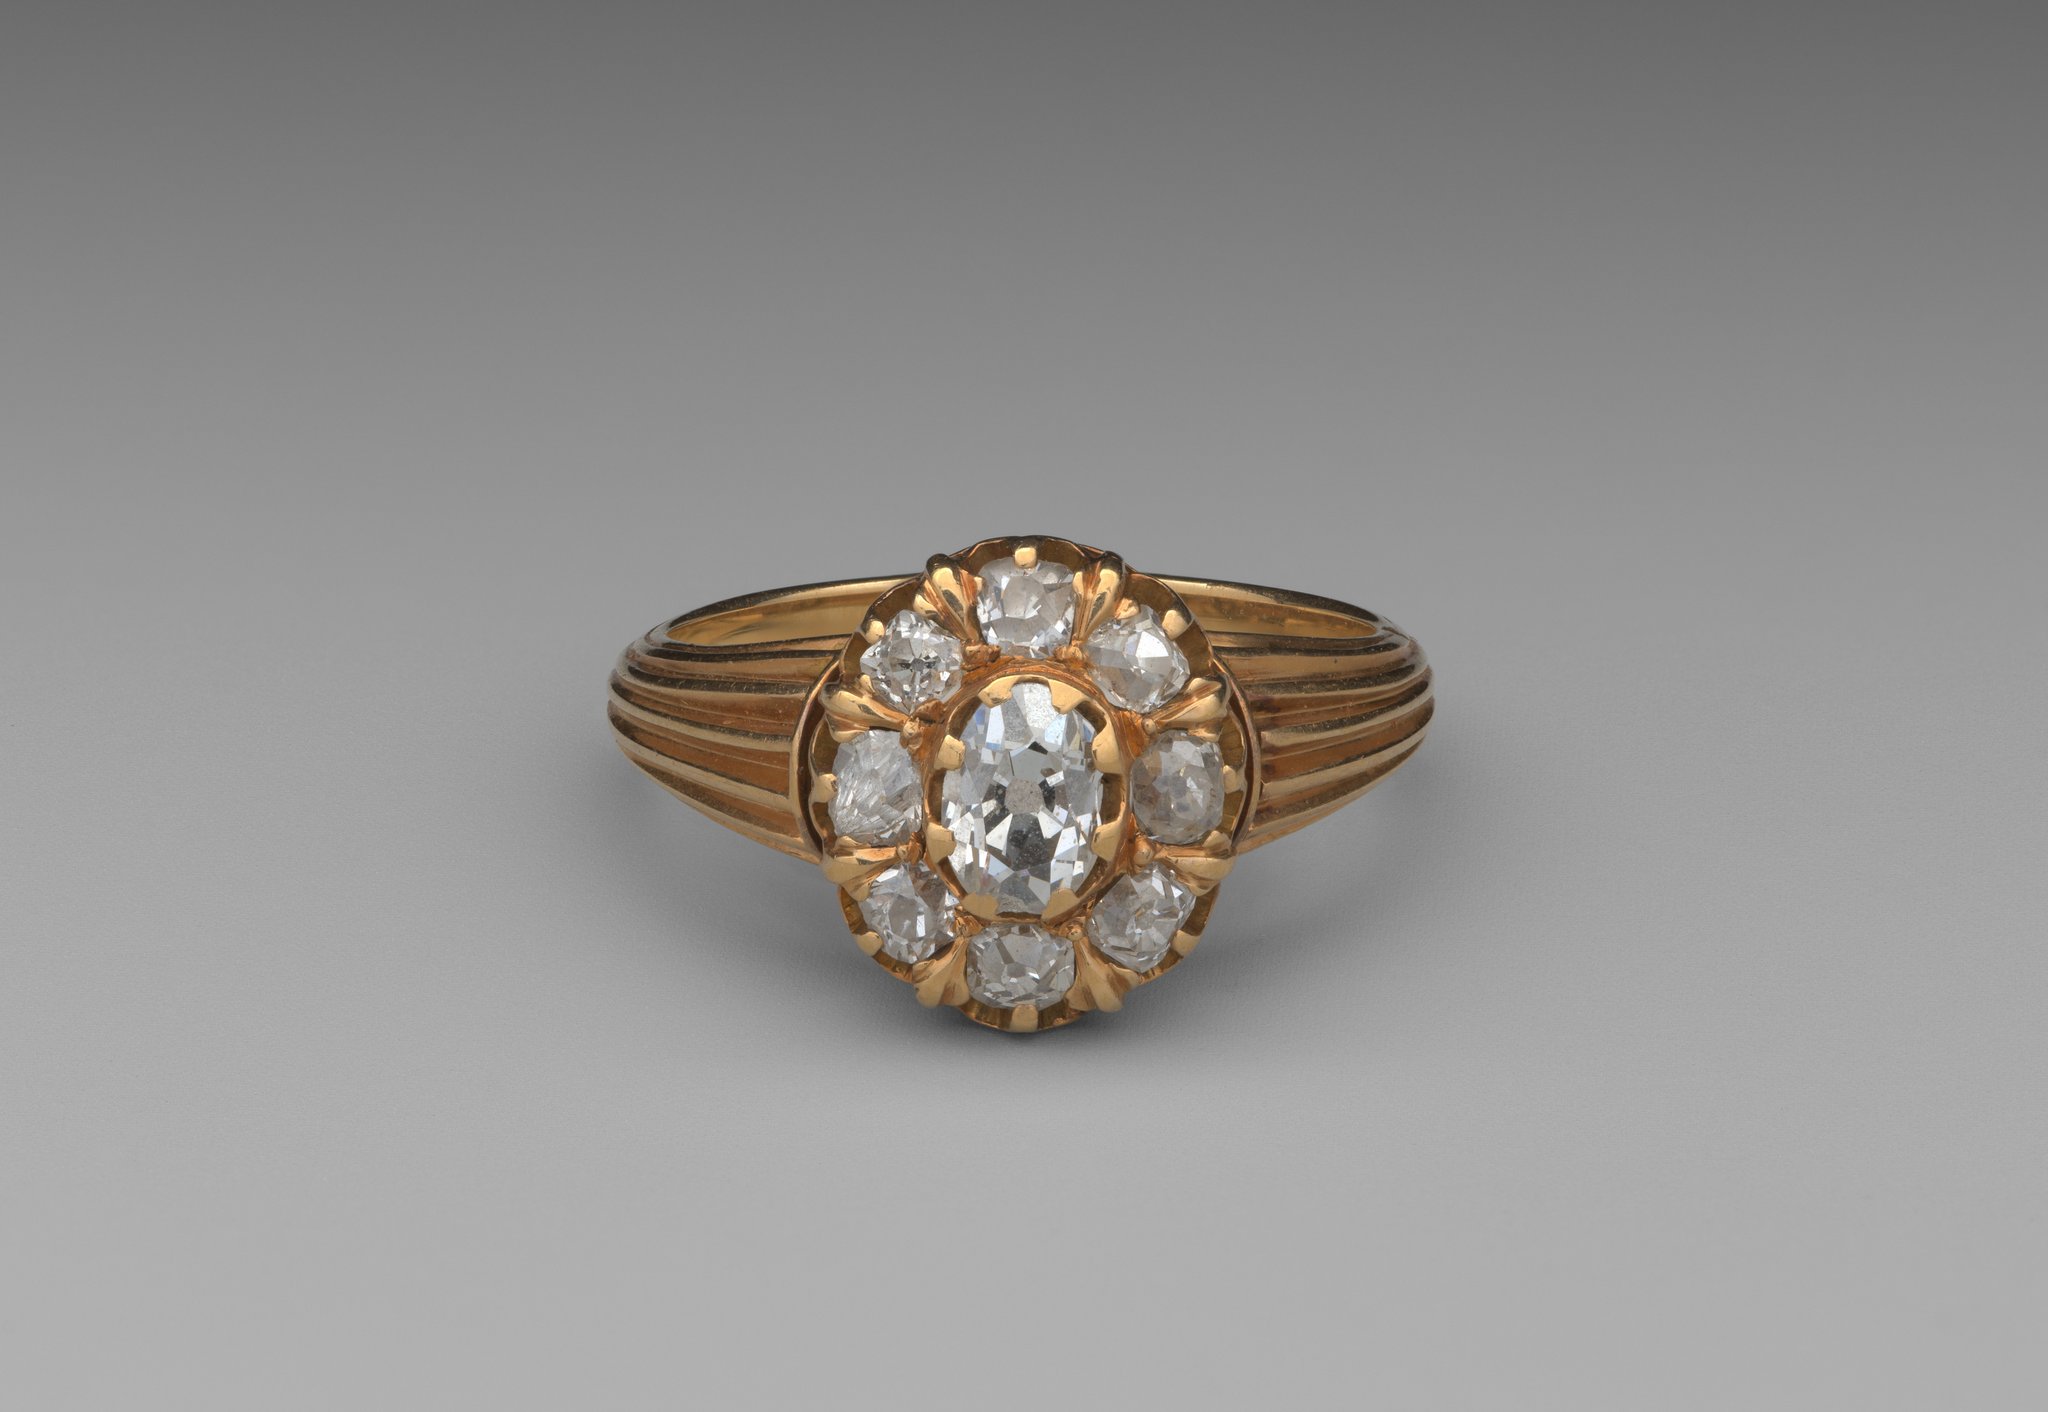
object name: ring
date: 1801-1900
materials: diamond, gold